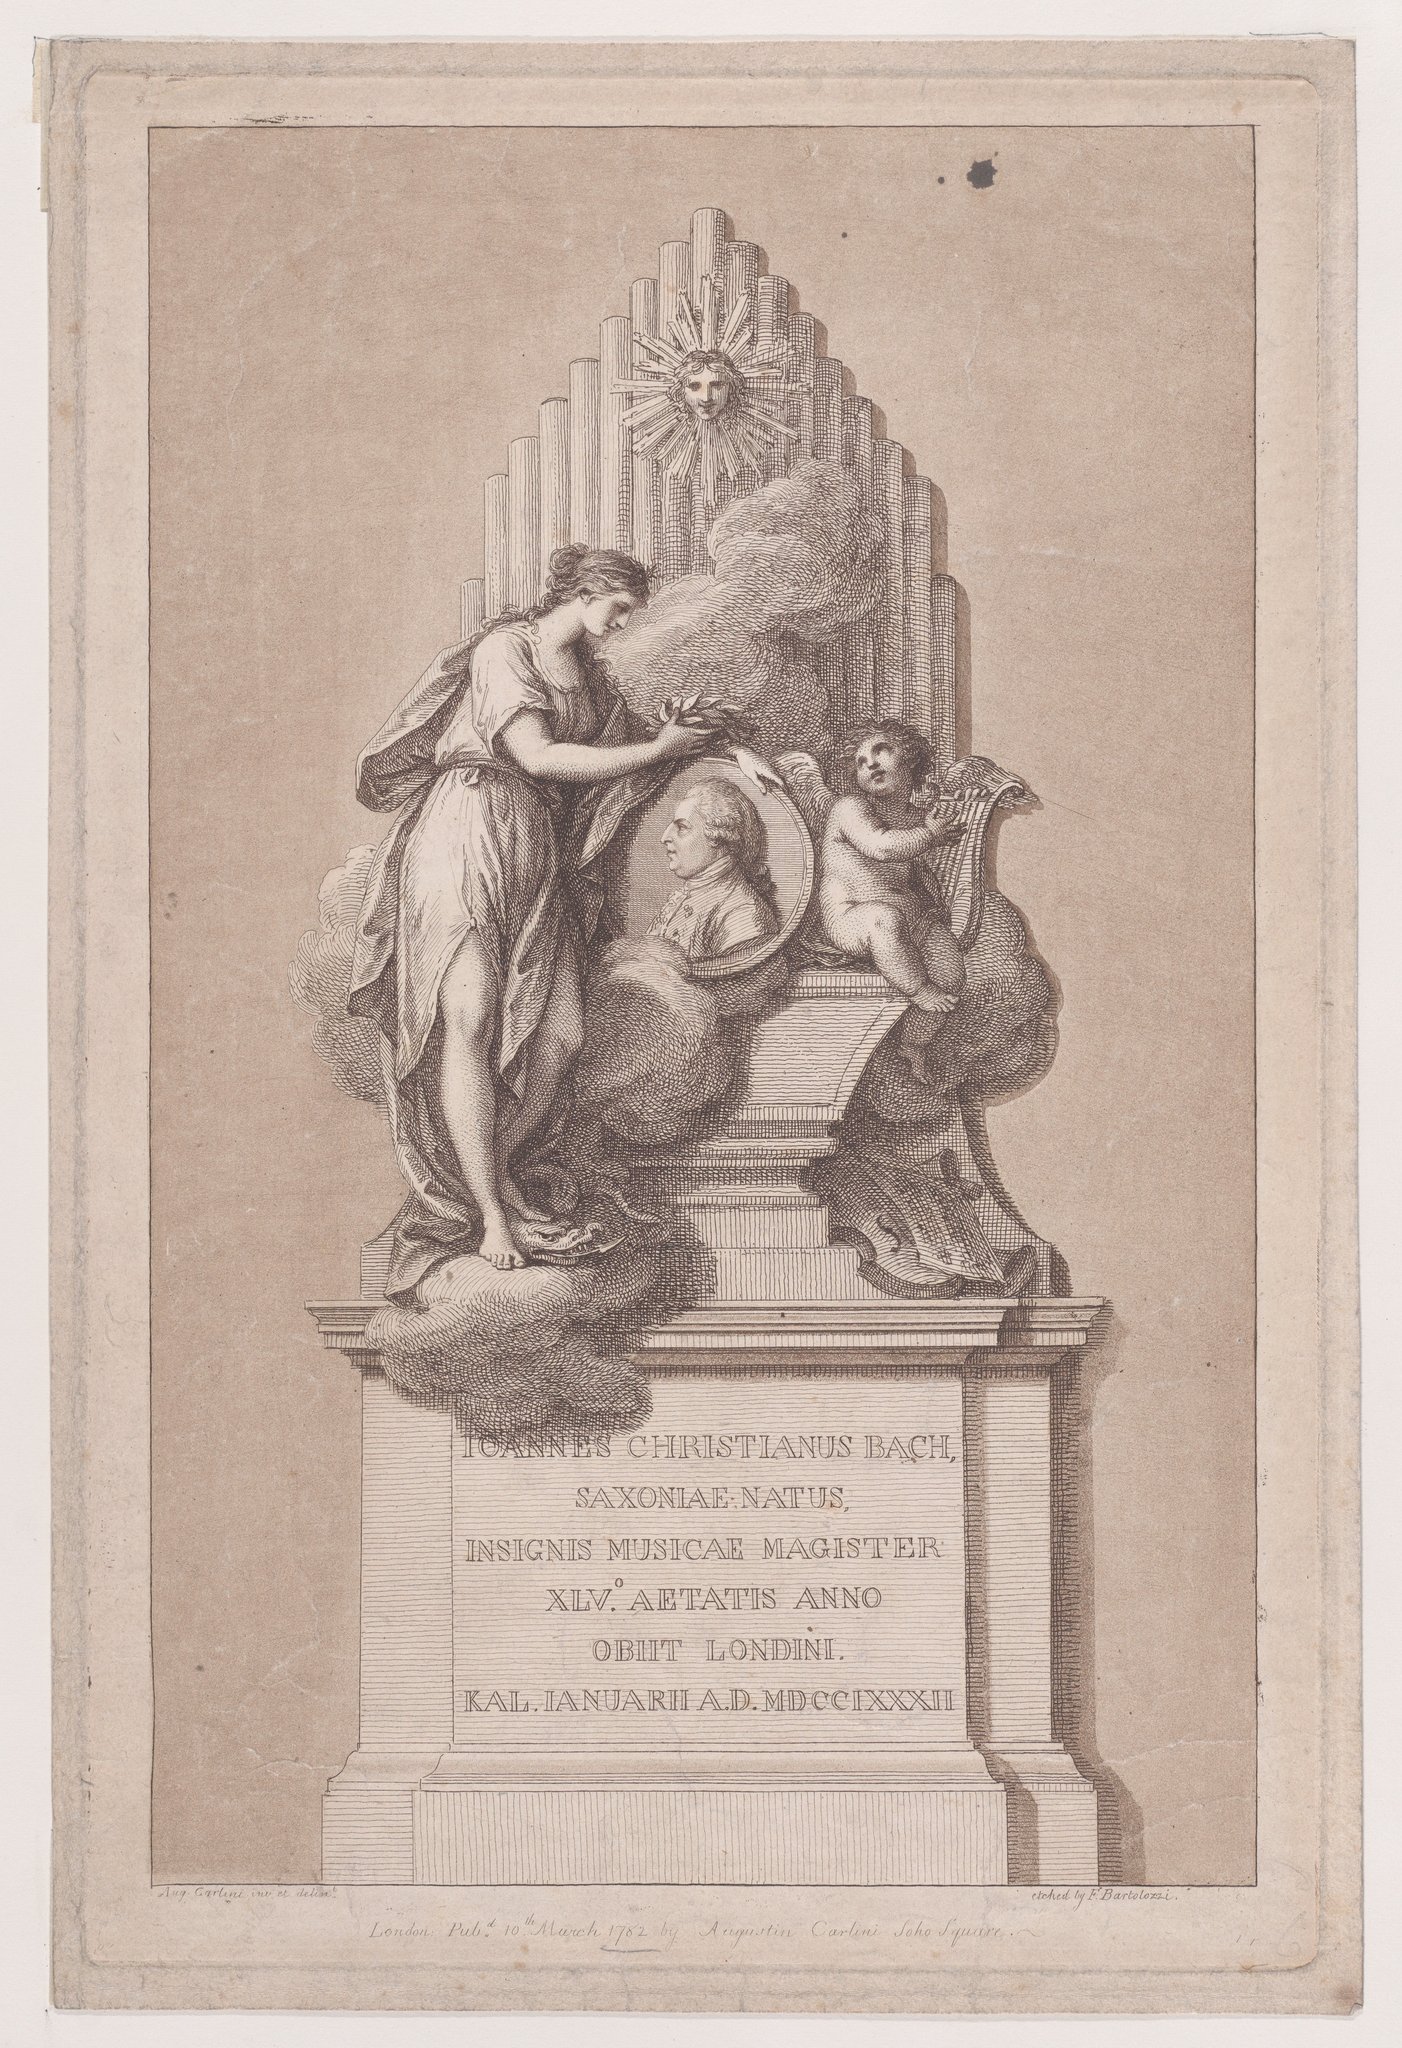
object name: print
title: Monument to Johann Christian Bach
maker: francesco bartolozzi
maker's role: artist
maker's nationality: italian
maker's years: 1728-1815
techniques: engraving, etching